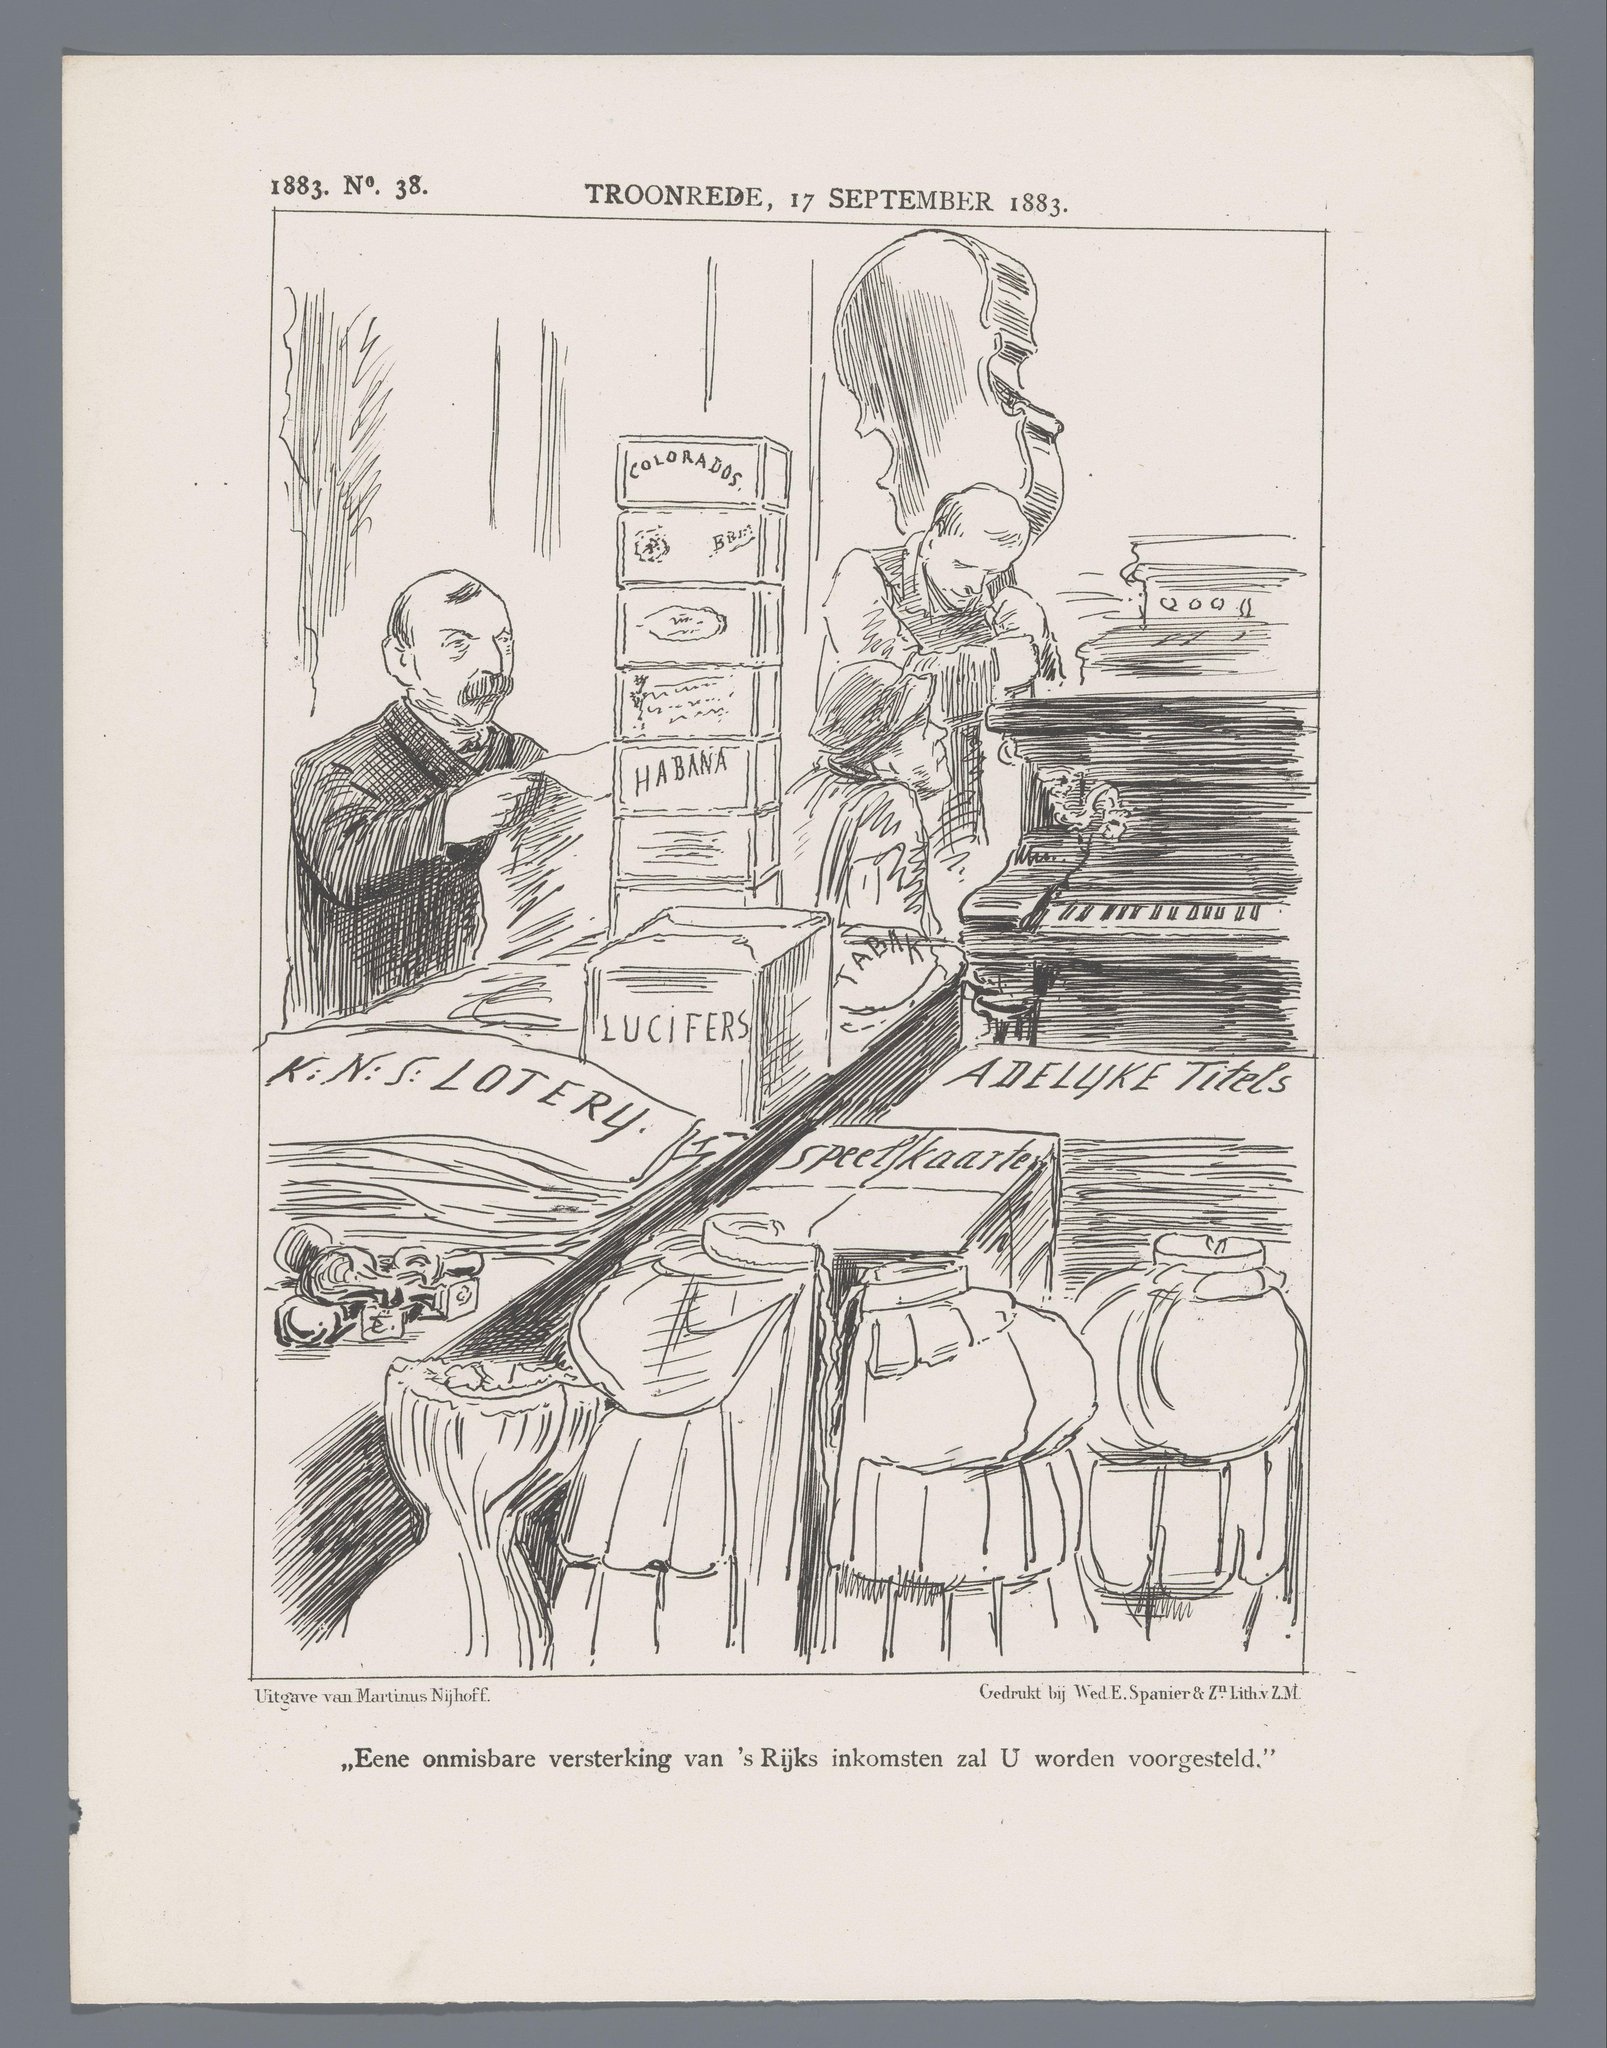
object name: cartoon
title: Troonrede, 17 September 1883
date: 1883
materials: paper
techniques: lithograph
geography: netherlands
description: Spotprent over de troonrede van 17 september 1883. Plaat verschenen bij het weekblad De Nederlandsche Spectator, nr. 38, 1883.